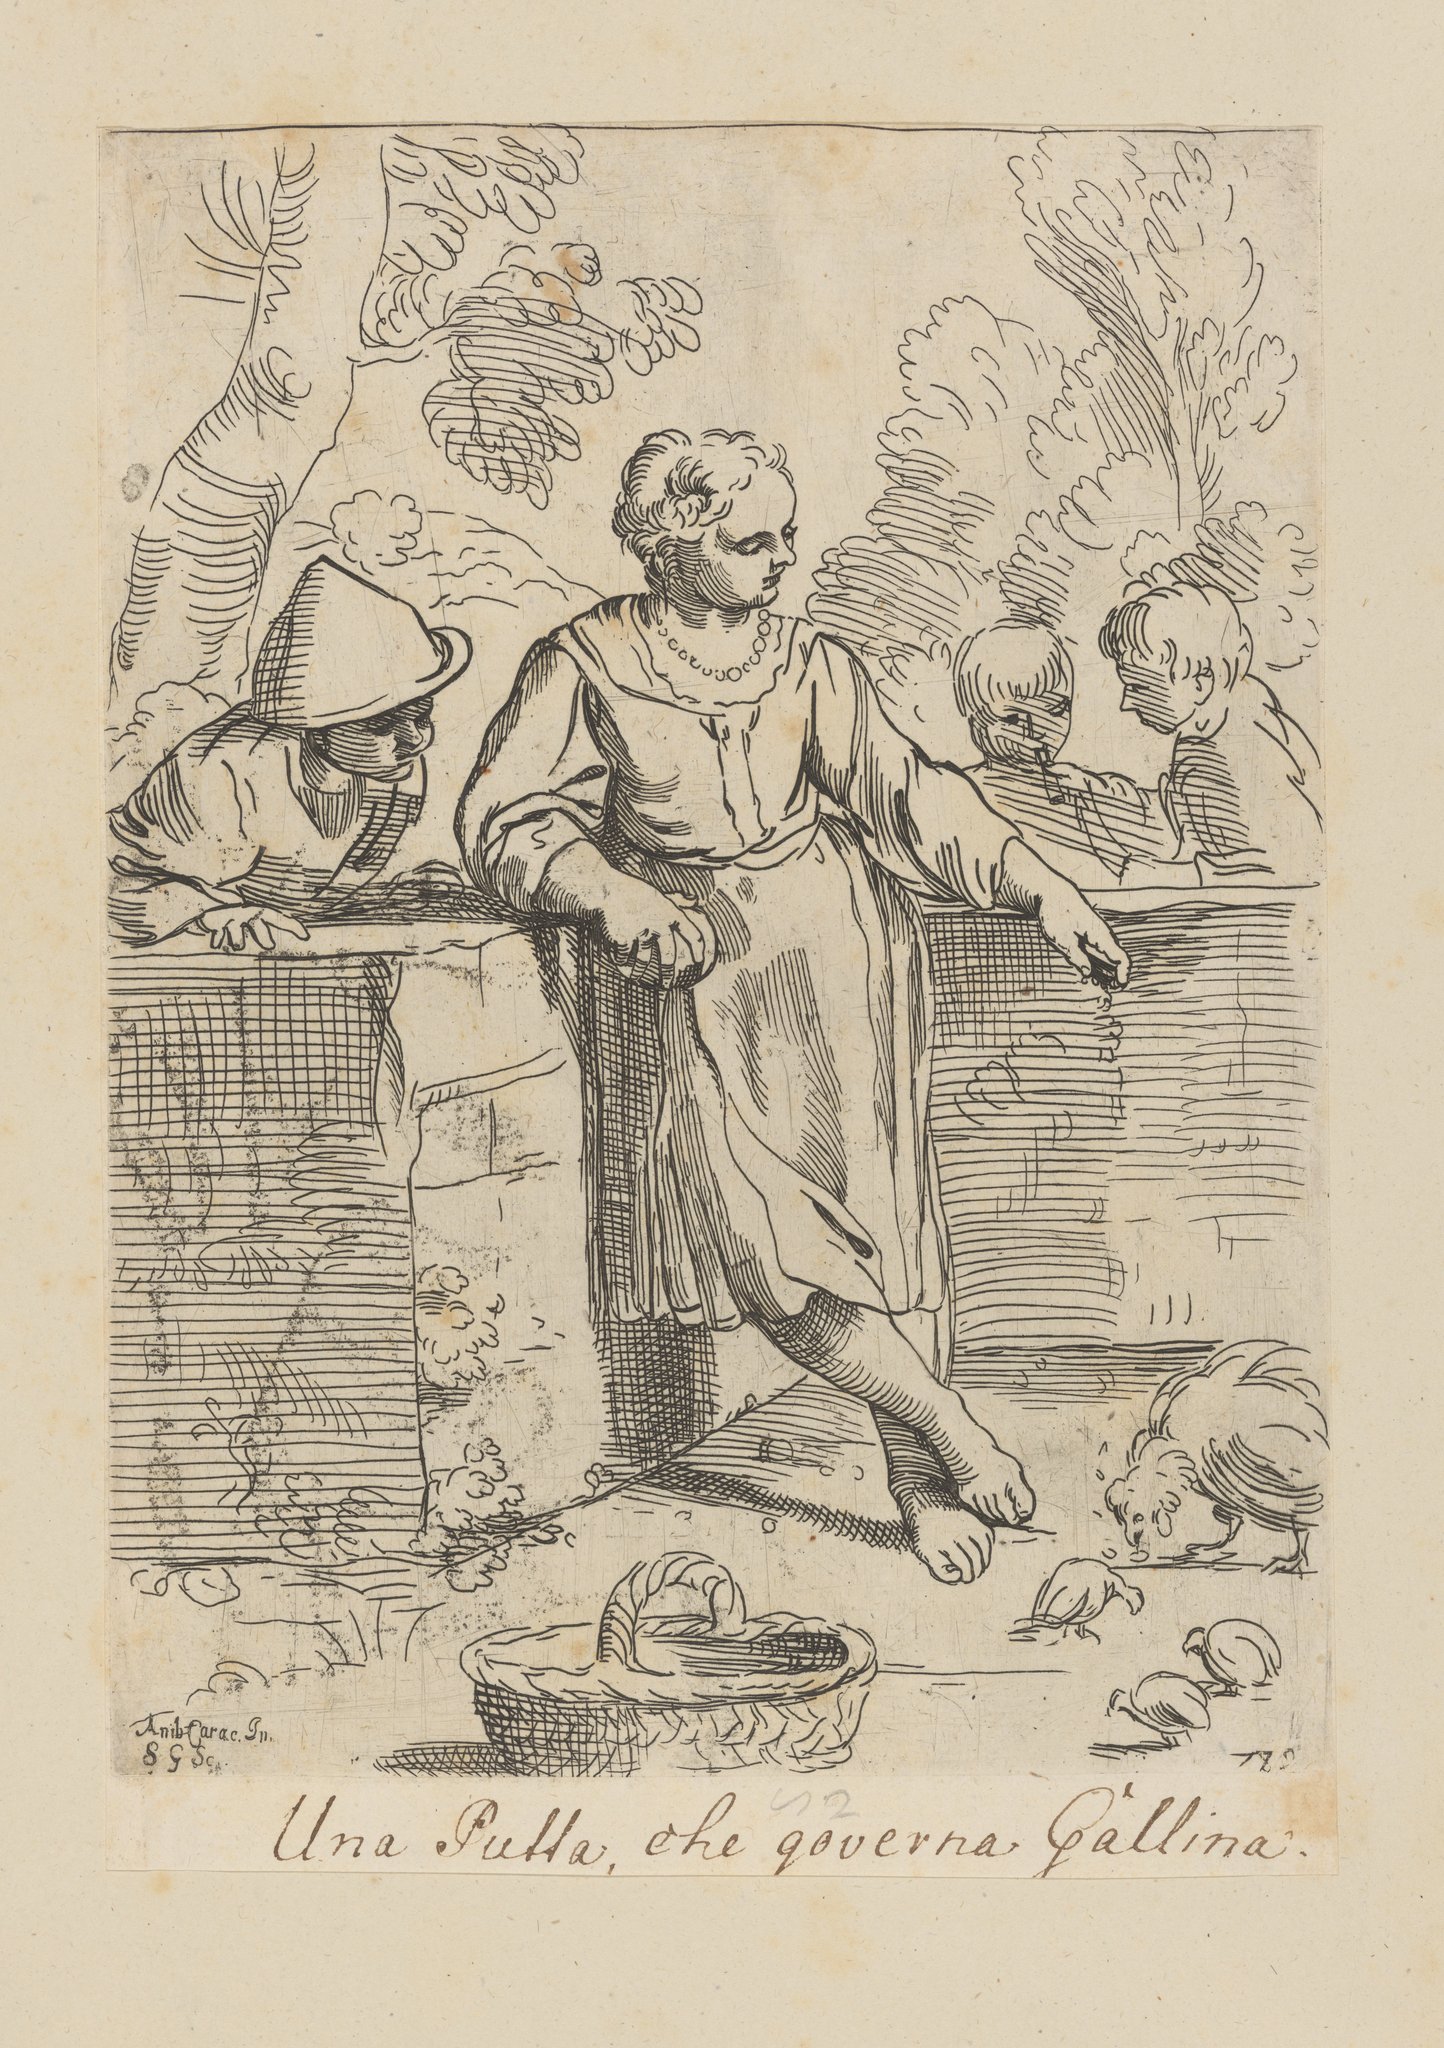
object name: print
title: Plate 78: Poultry maid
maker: simon guillain ii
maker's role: artist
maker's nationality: french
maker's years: 1618-1718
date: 1646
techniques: etching